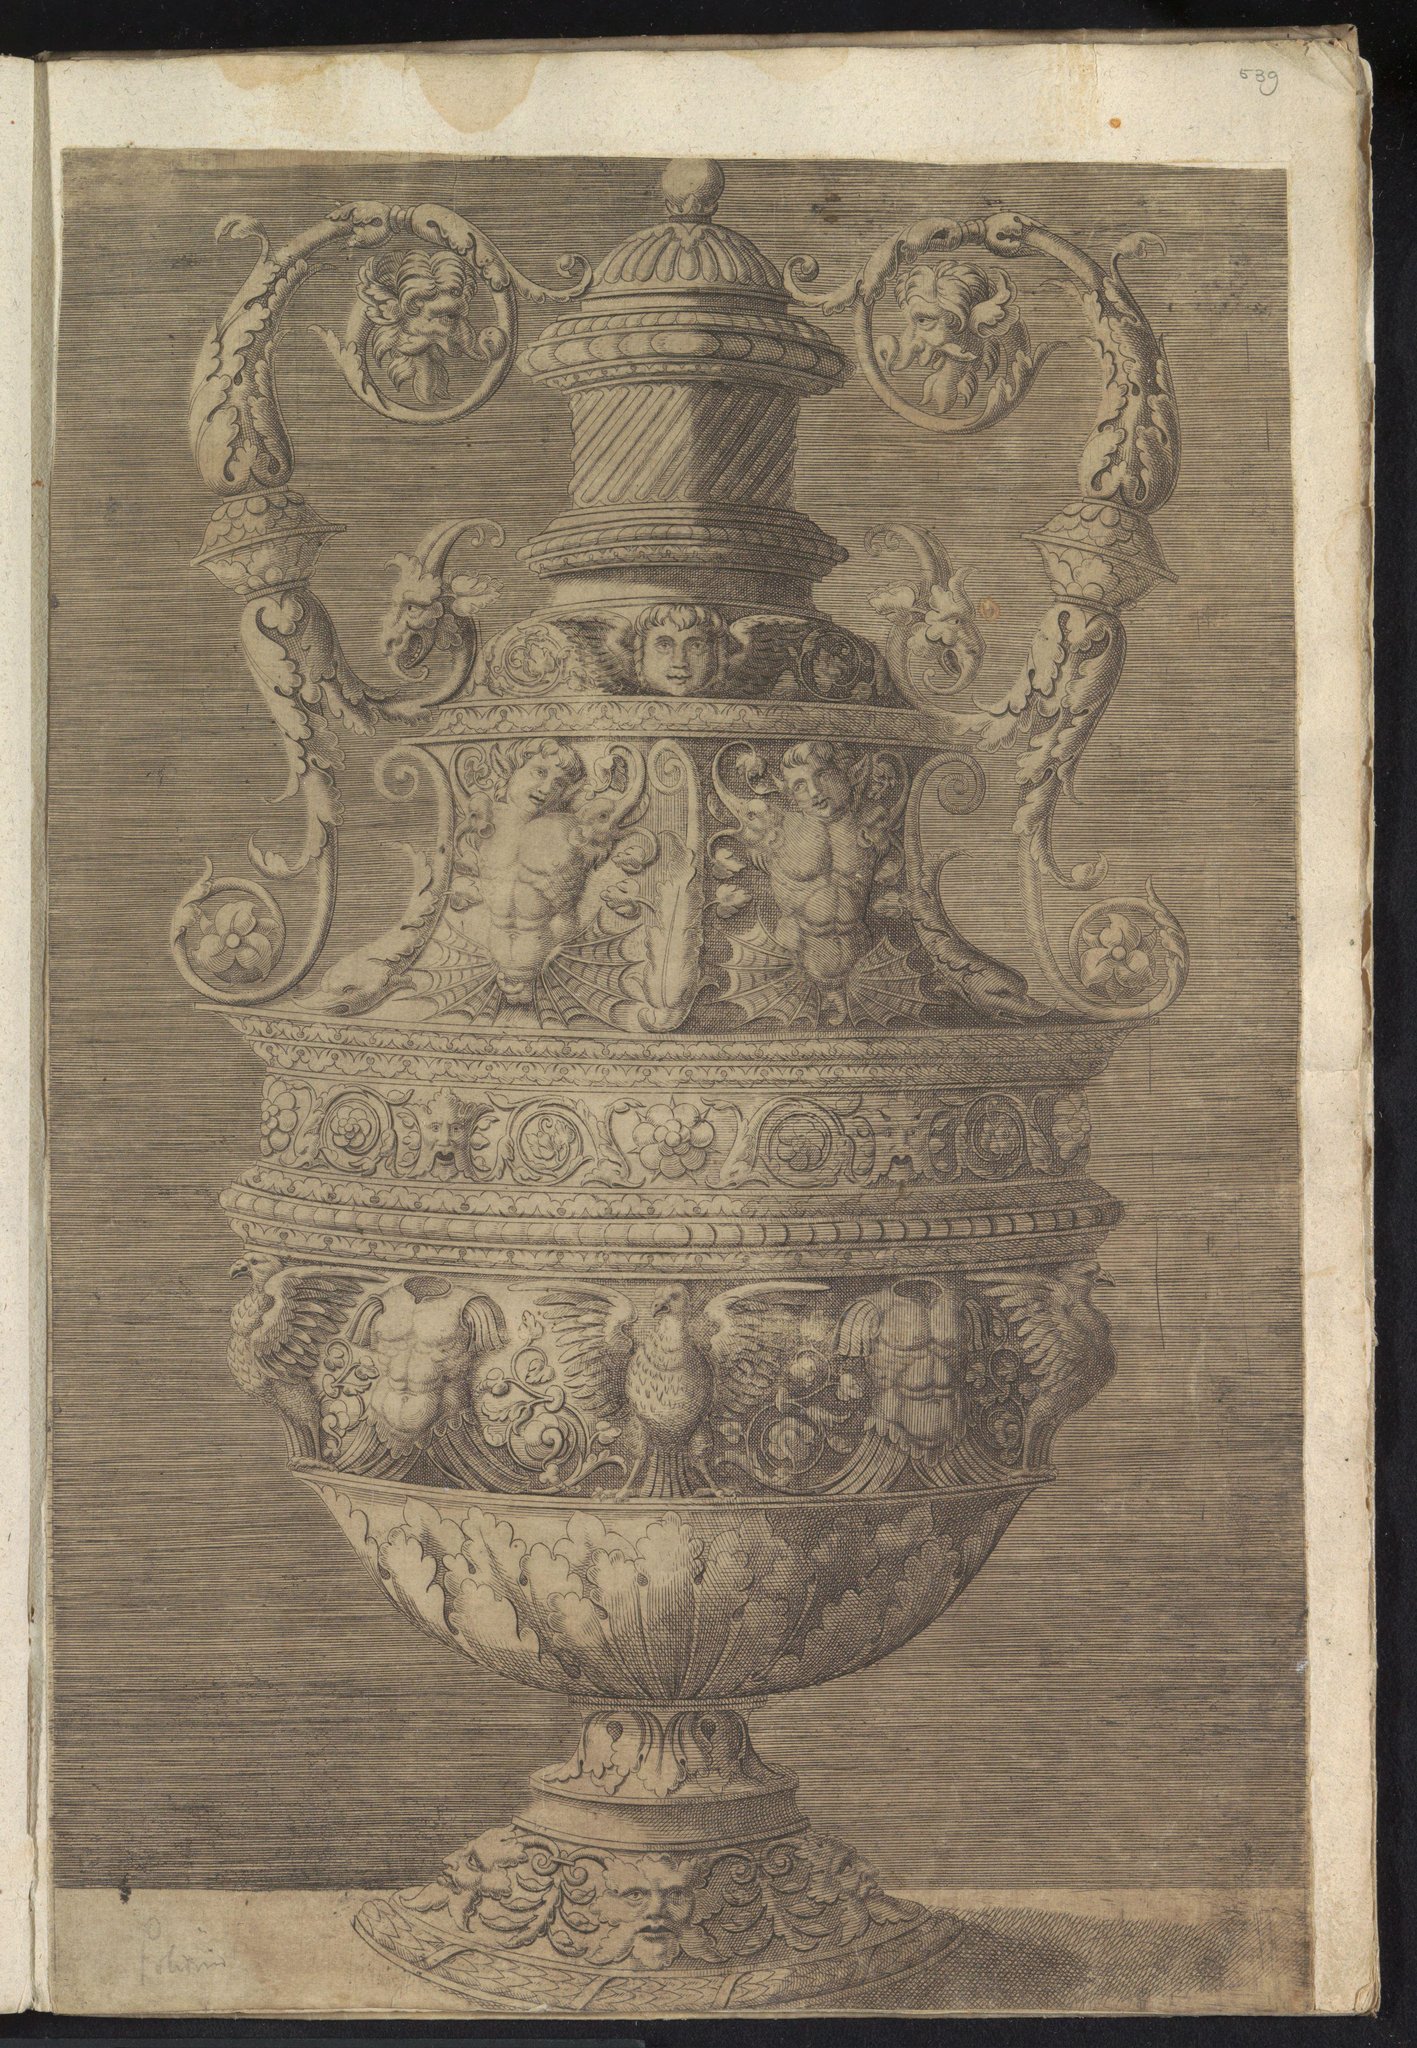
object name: print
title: Albumblad met een prent van een vaas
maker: Anonymous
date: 1500-1599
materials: paper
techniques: engraving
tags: vase ~ ornament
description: Albumblad met een uitgeknipte prent van een ornamentele vaas.